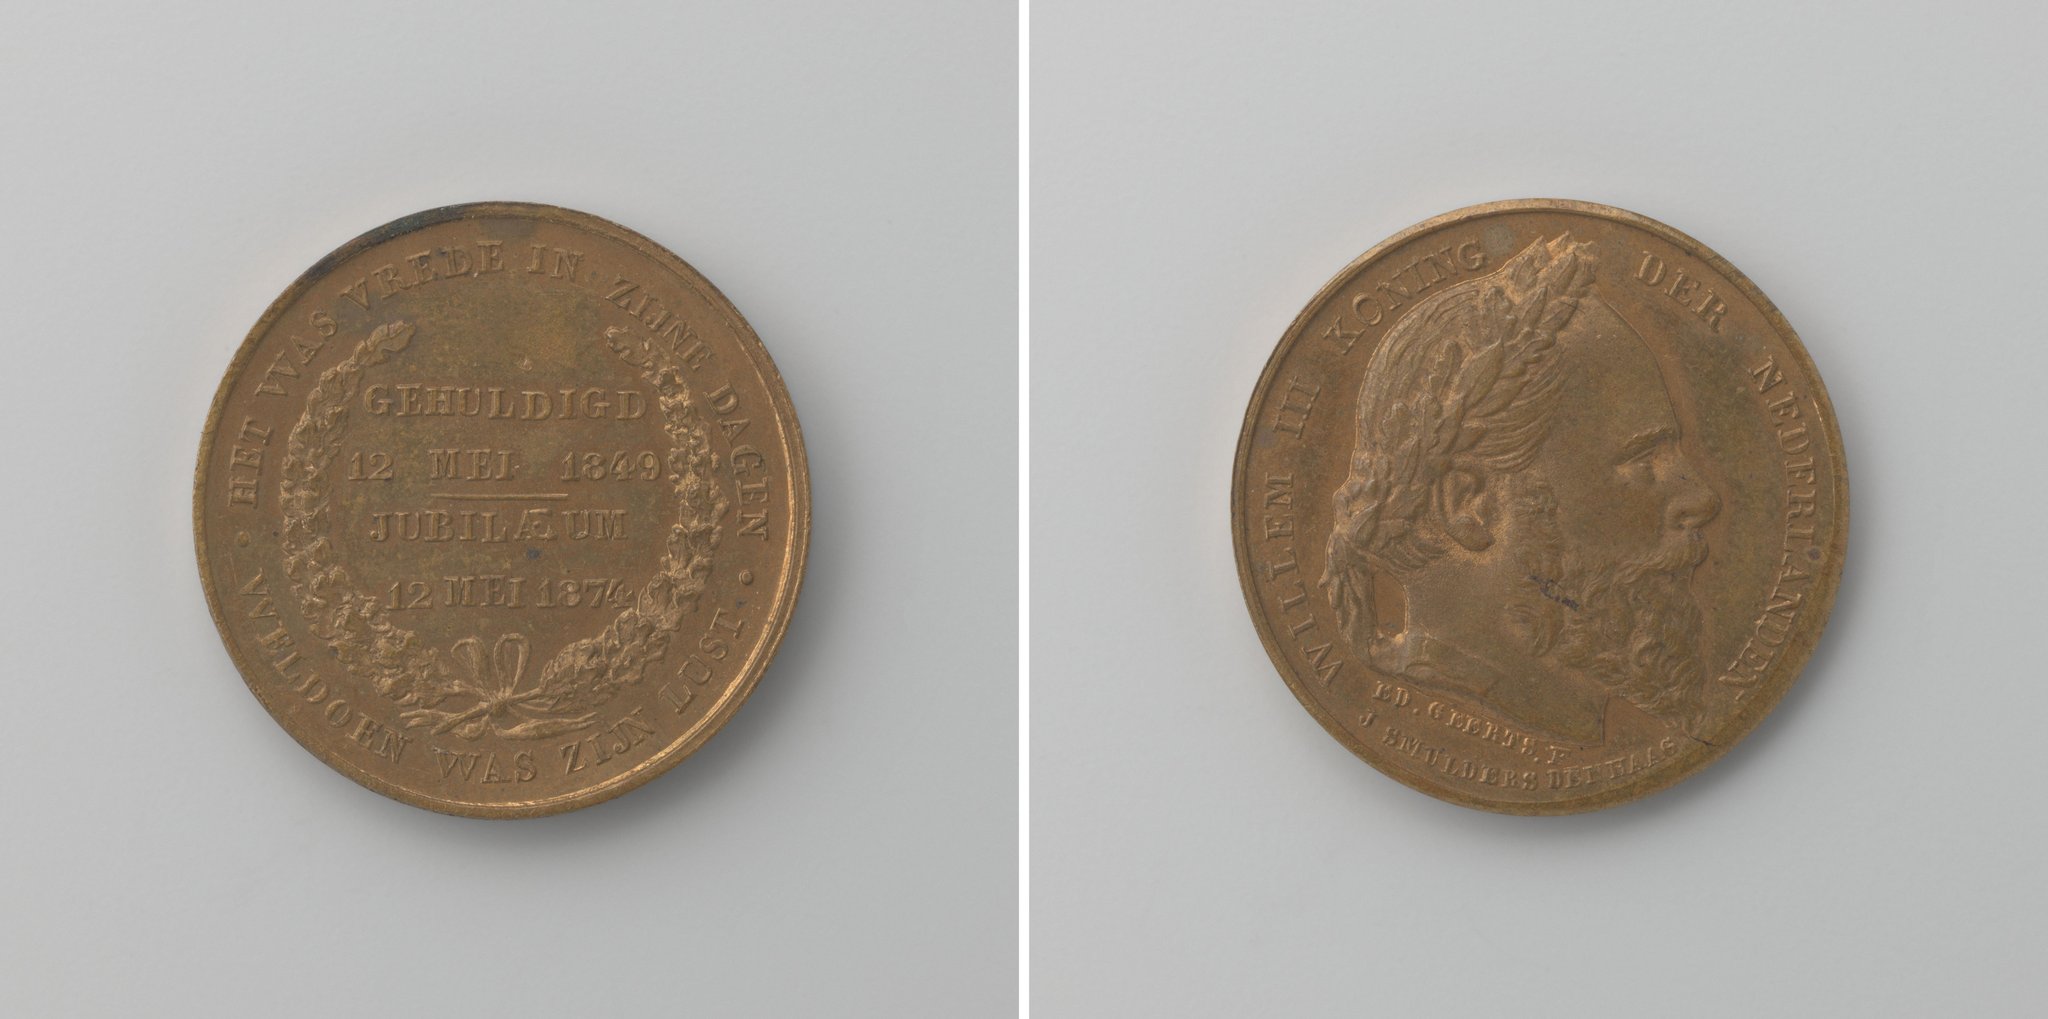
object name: history medal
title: Vijfentwintigjarig regeringsjubileum van Koning Willem III 1874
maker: edouard louis geerts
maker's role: medailleur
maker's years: 1846-1889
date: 1874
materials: brass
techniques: striking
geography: the hague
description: Verguld koperen penning, op de voorzijde het bekranste portret van Willem III naar rechts met omschrift, op de keerzijde vier regels tekst tussen samengestrikte eikentakken, met omschrift.